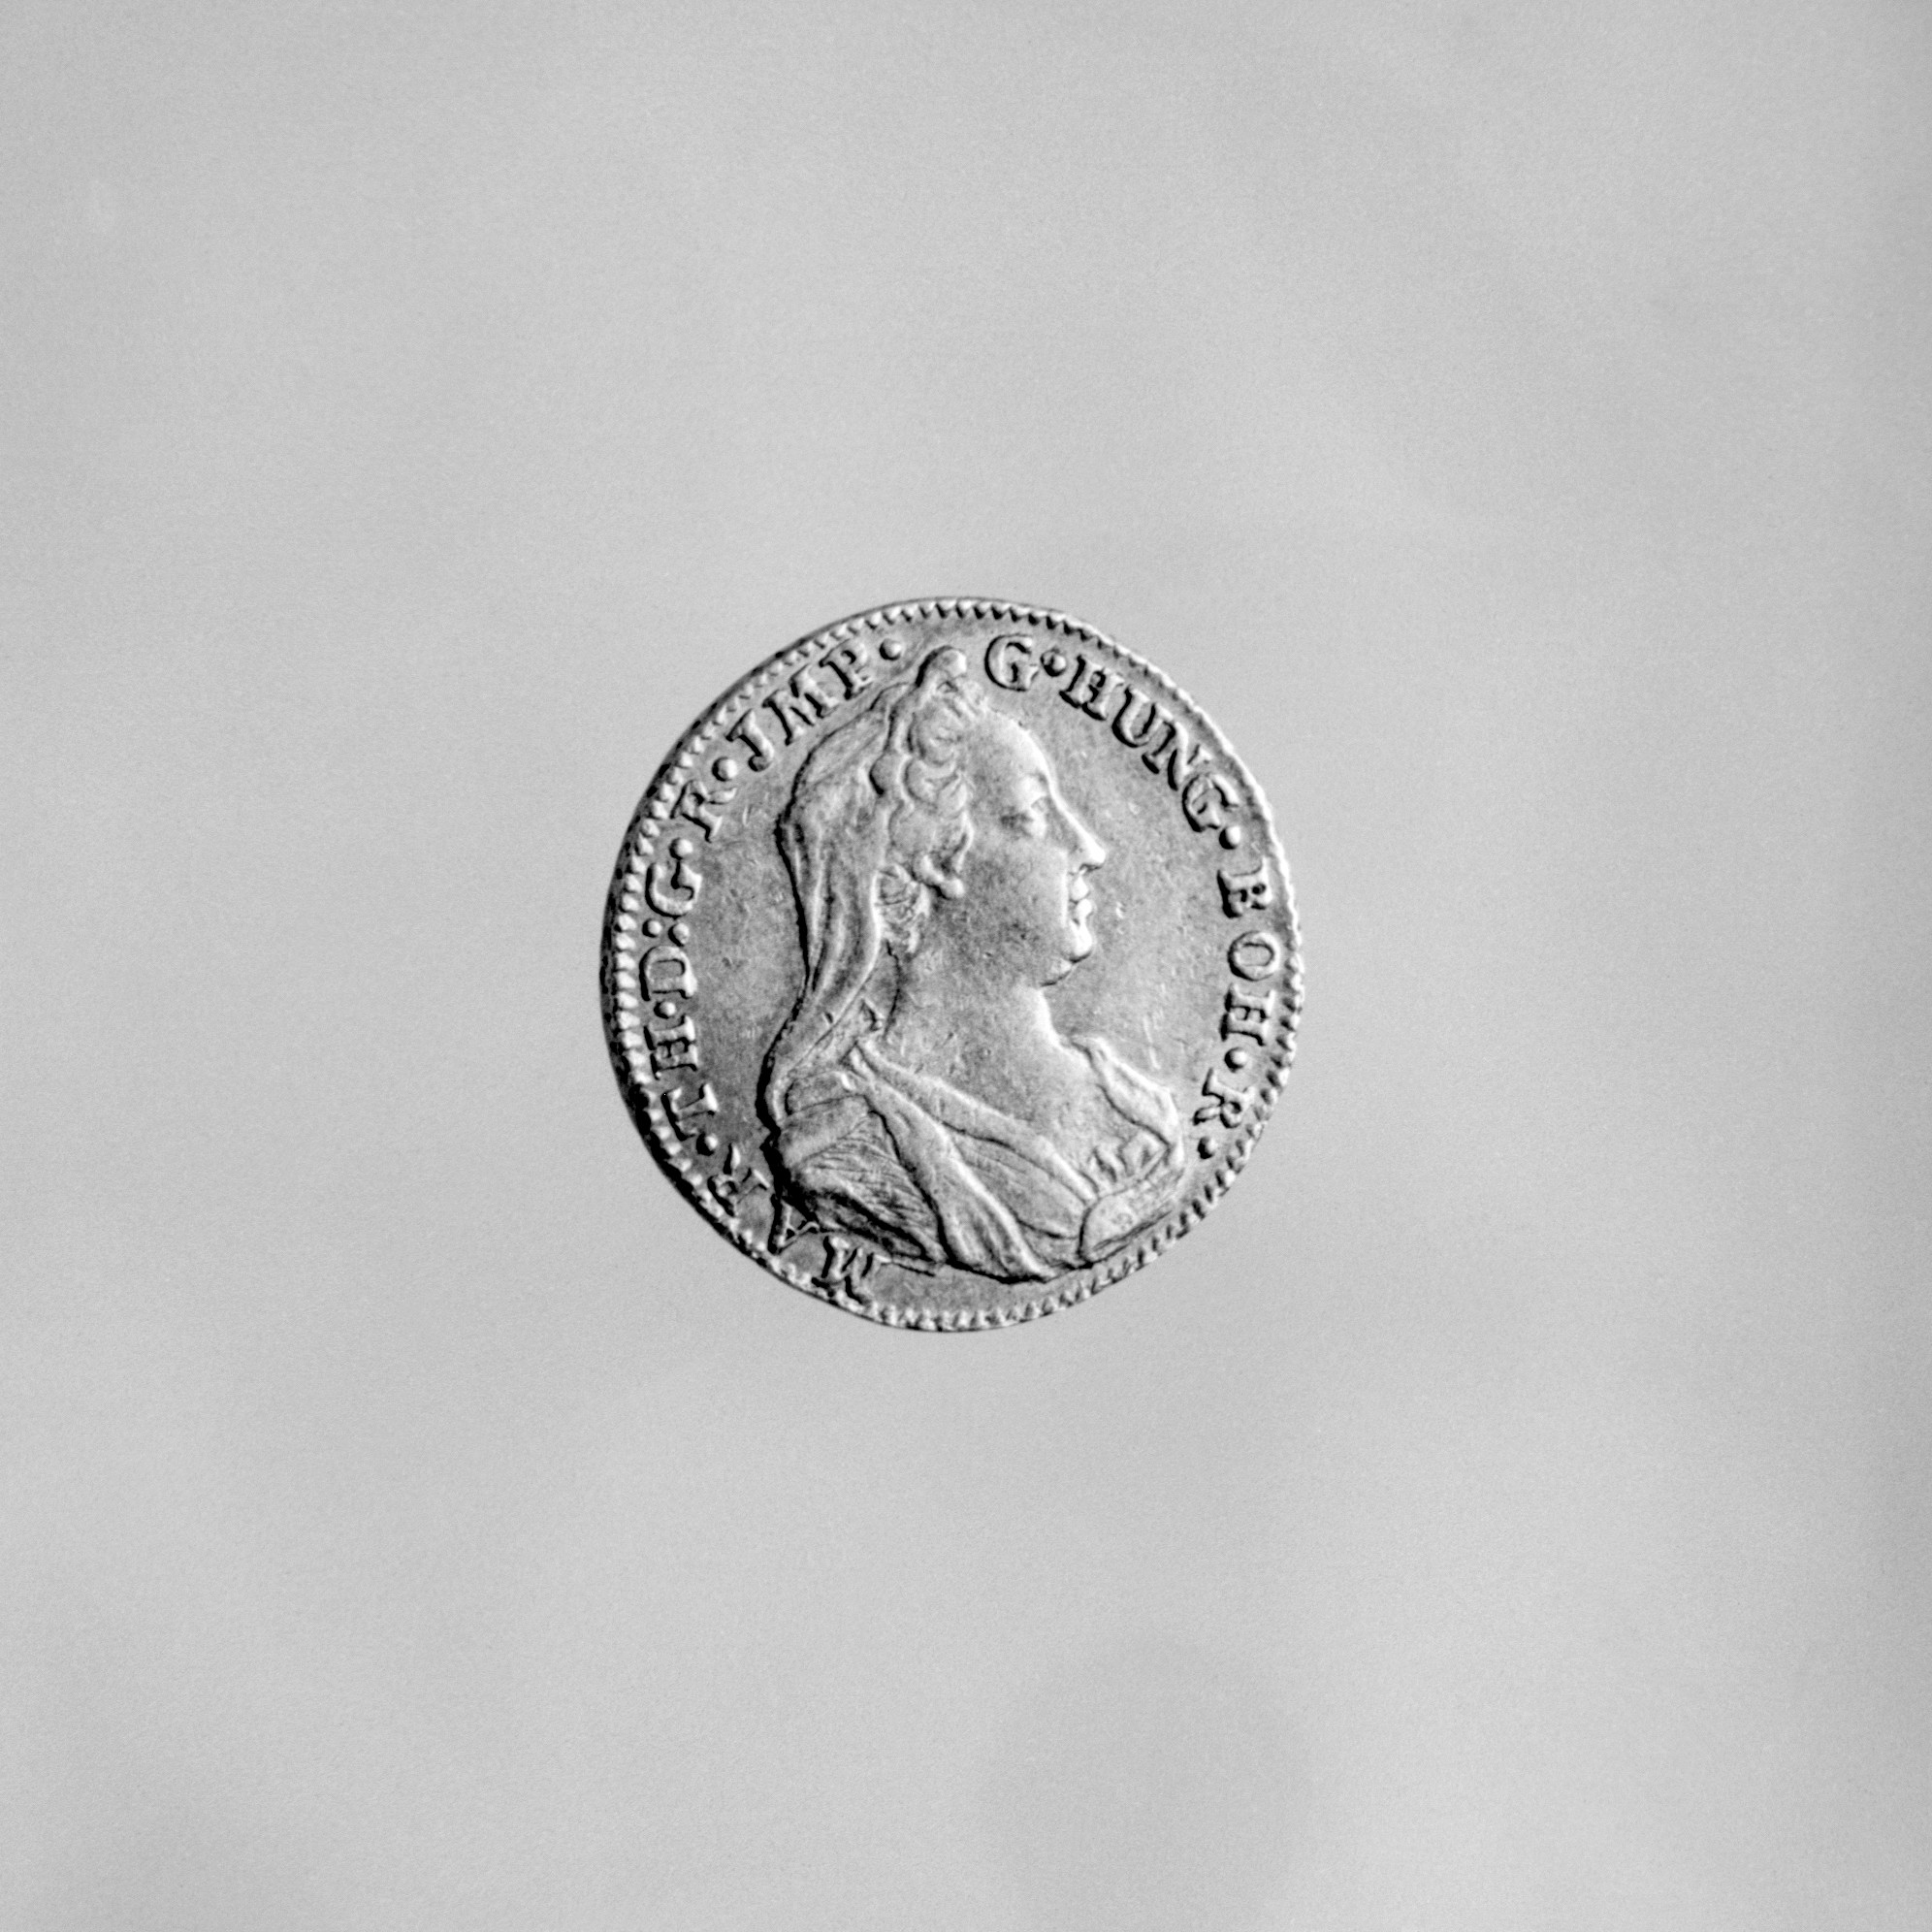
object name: coin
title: Maria-Theresa, Empress of the Holy Roman Empire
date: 1775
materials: gold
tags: profiles,women